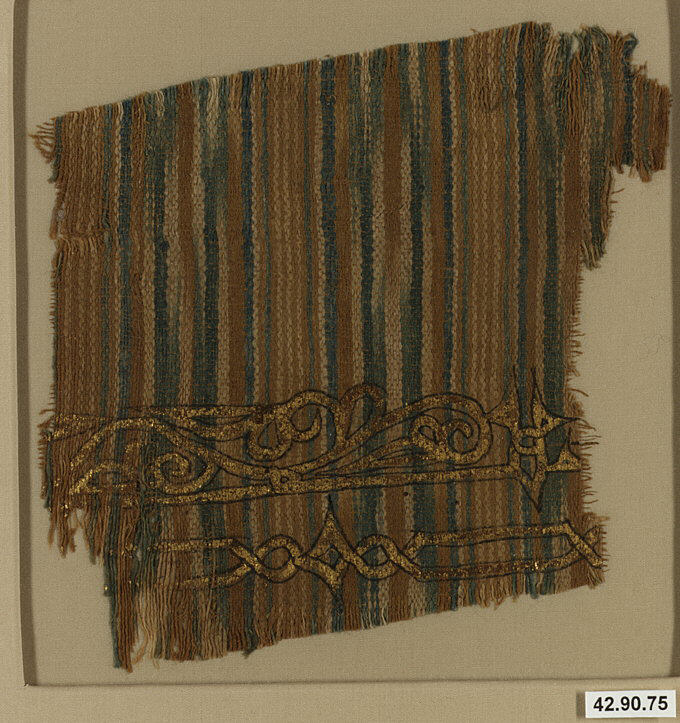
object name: textile fragment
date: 901-1000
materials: cotton, gold, ink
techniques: dyeing, painting, weave, resist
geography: yemen